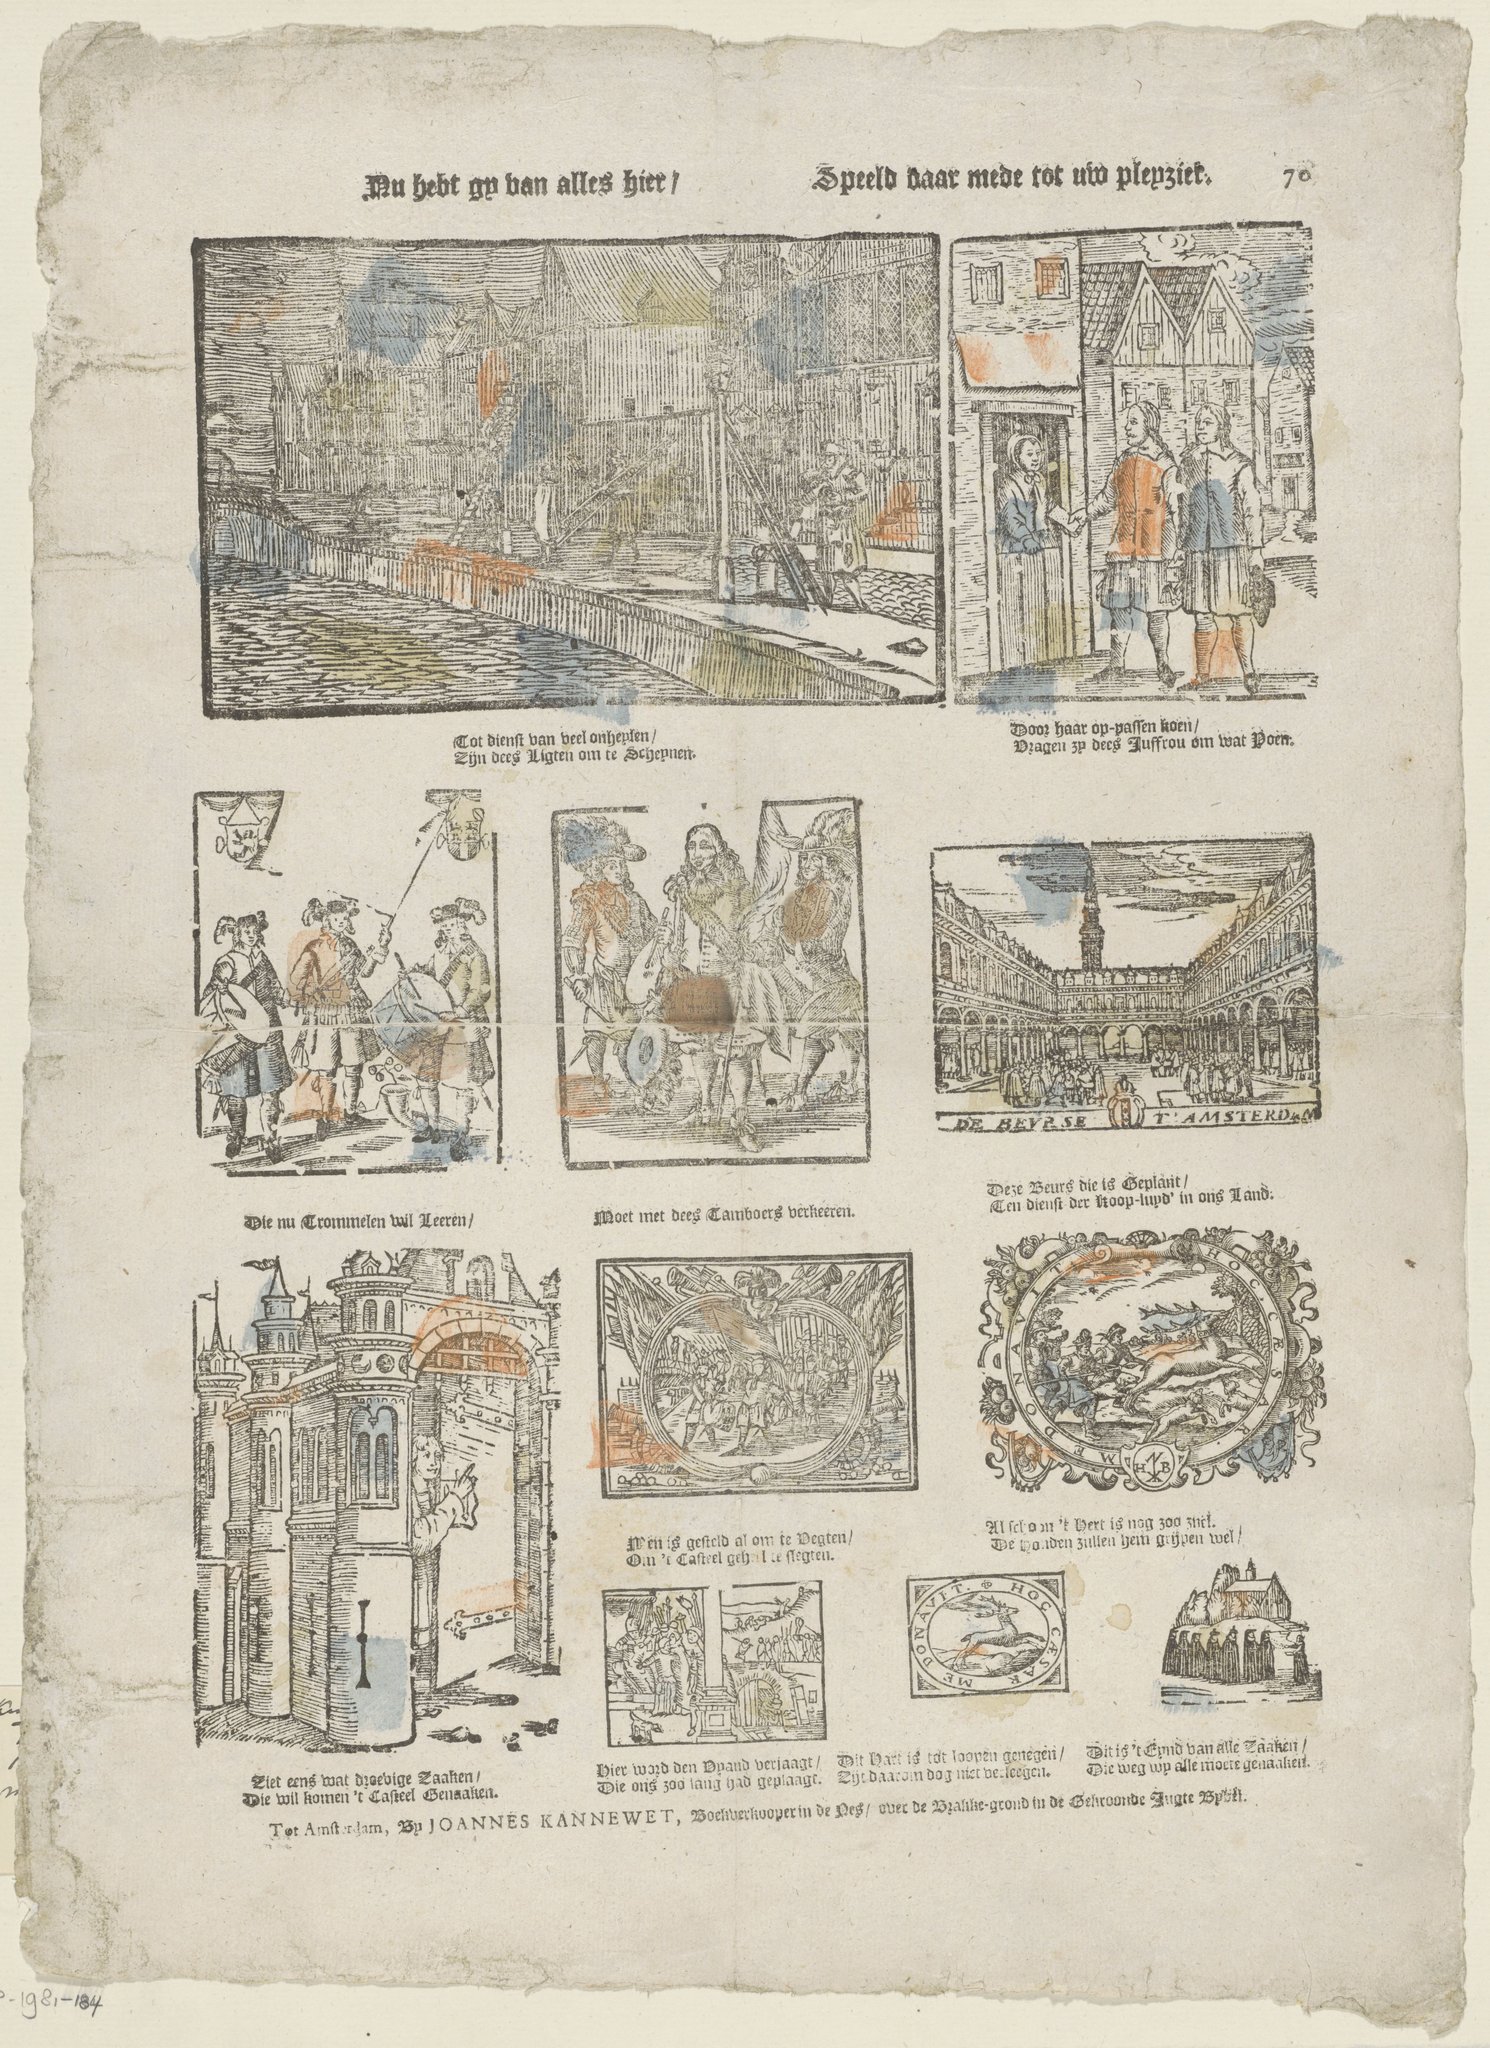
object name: print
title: Nu hebt gy van van alles hier / Speeld daar mede tot uw pleyzier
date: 1725-1780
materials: paper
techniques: colour, letterpress printing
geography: amsterdam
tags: hunt ~ mammals, drum (musical instrument) - cc - out of doors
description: Blad met 11 voorstellingen van verschillende aard, waaronder voorstellingen van tamboers, jagers met honden die op een hert jagen en de Beurs van Hendrik de Keyser te Amsterdam. Onder elke afbeelding een tweeregelig vers. Genummerd rechtsboven: 70.